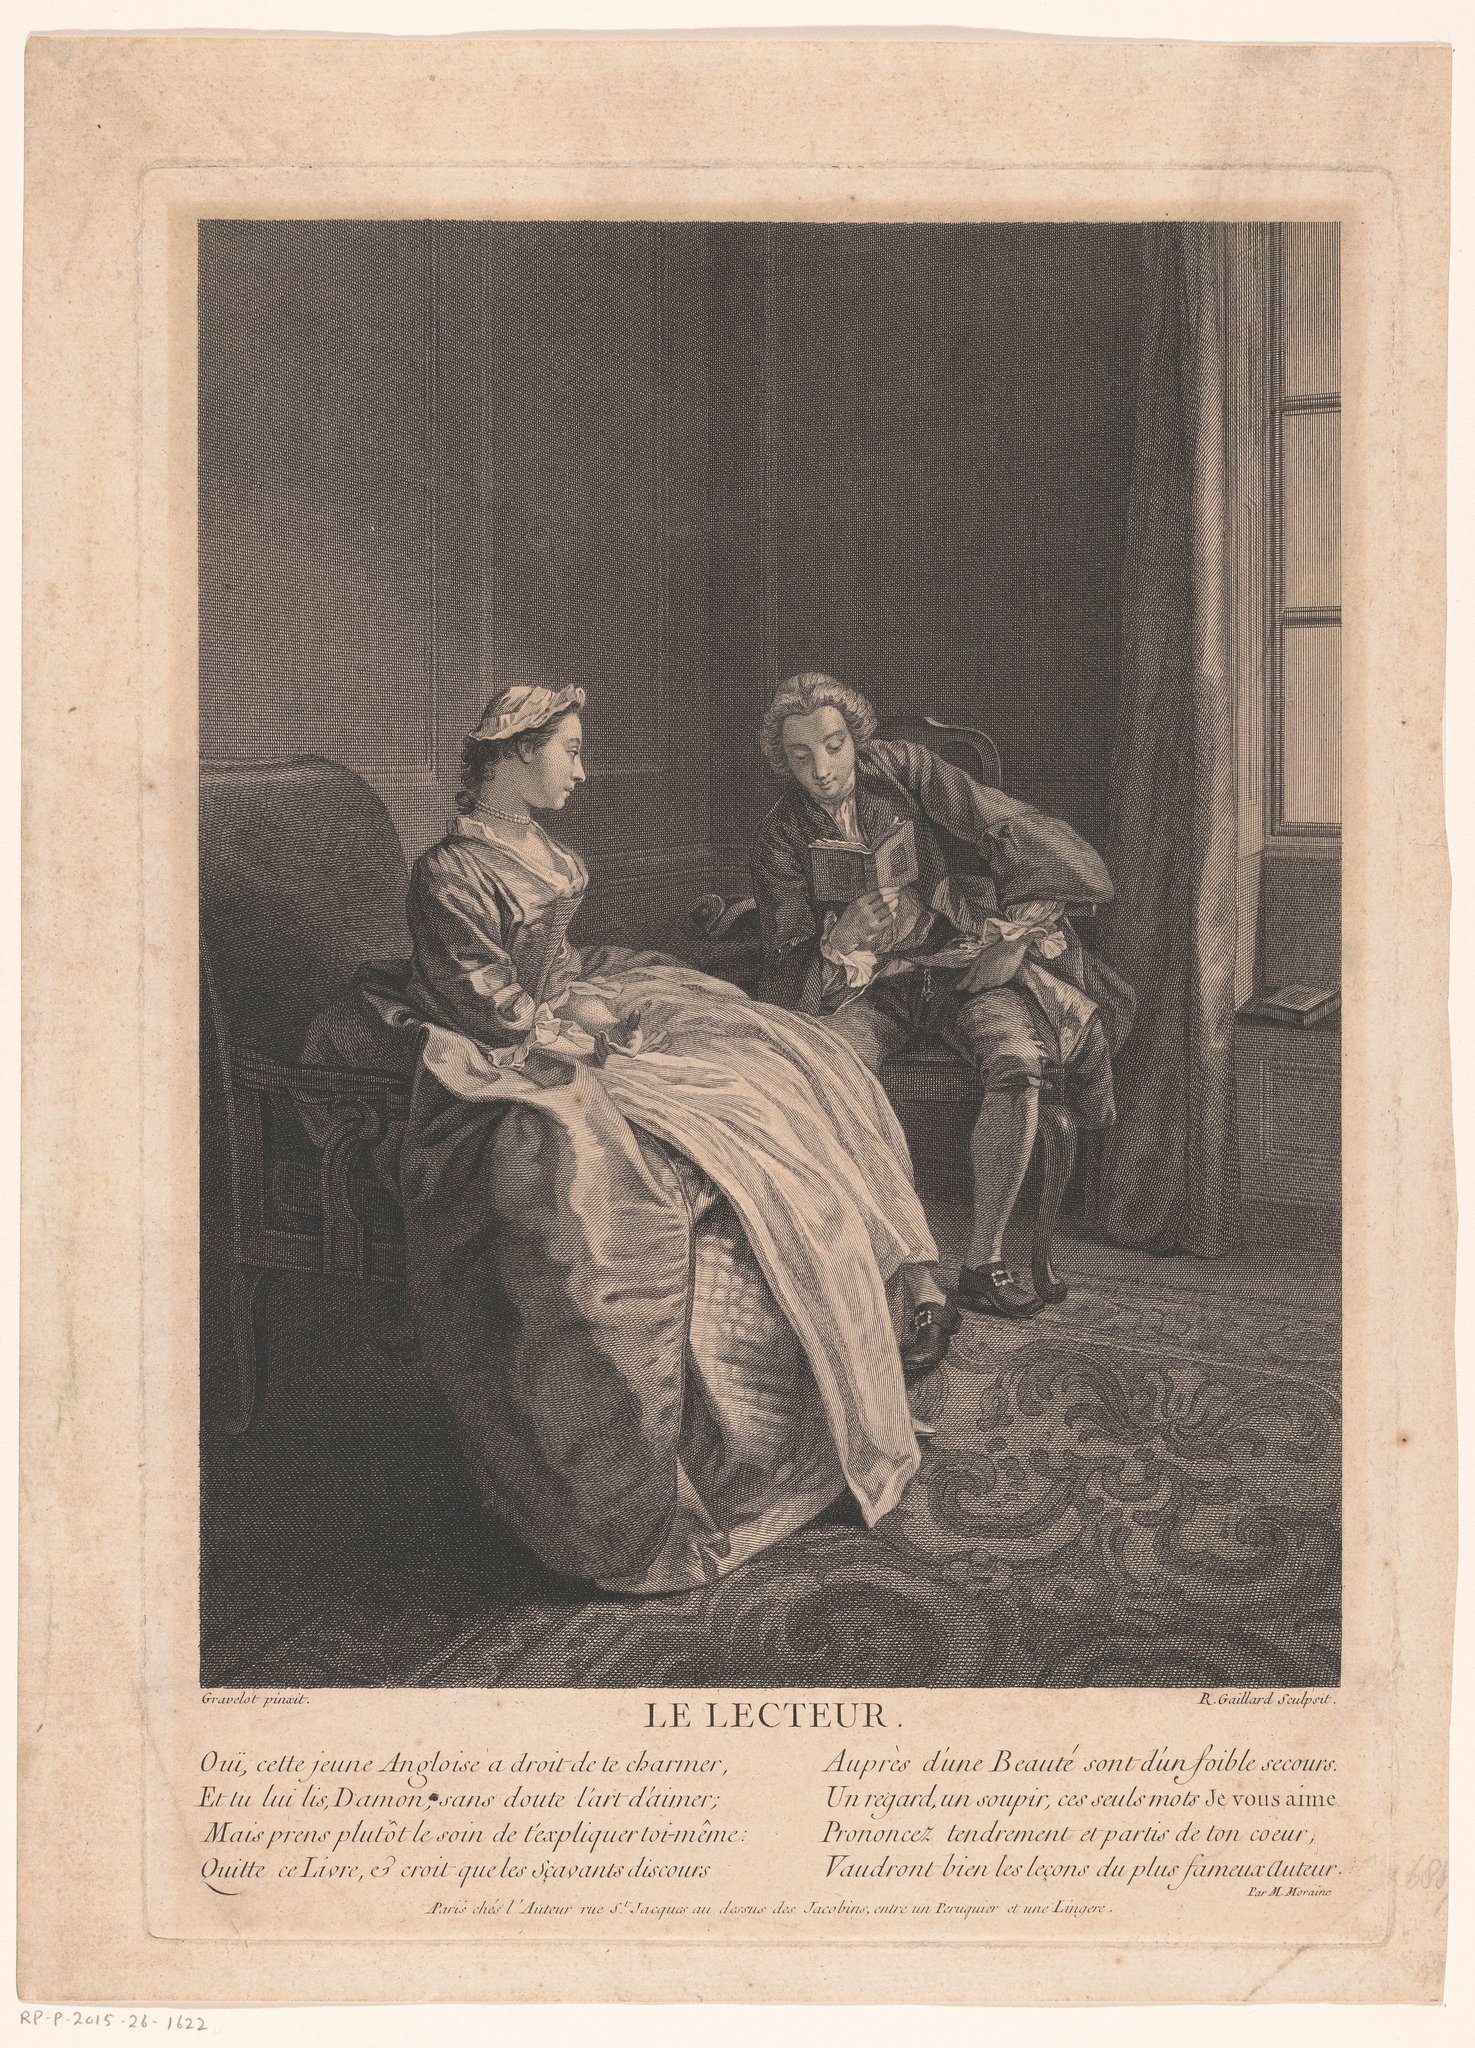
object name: print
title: Le lecteur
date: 1756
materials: paper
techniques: engraving, etching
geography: paris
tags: book, reading to somebody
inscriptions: collector's mark: Lugt 2228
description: Interieur met een jonge vrouw in een lange jurk, zittend op een stoel met haar handen in haar schoot. Naast haar zit een jonge man op een stoel, hij leest voor uit een boek. Onder de afbeelding een achtregelig vers in het Frans.